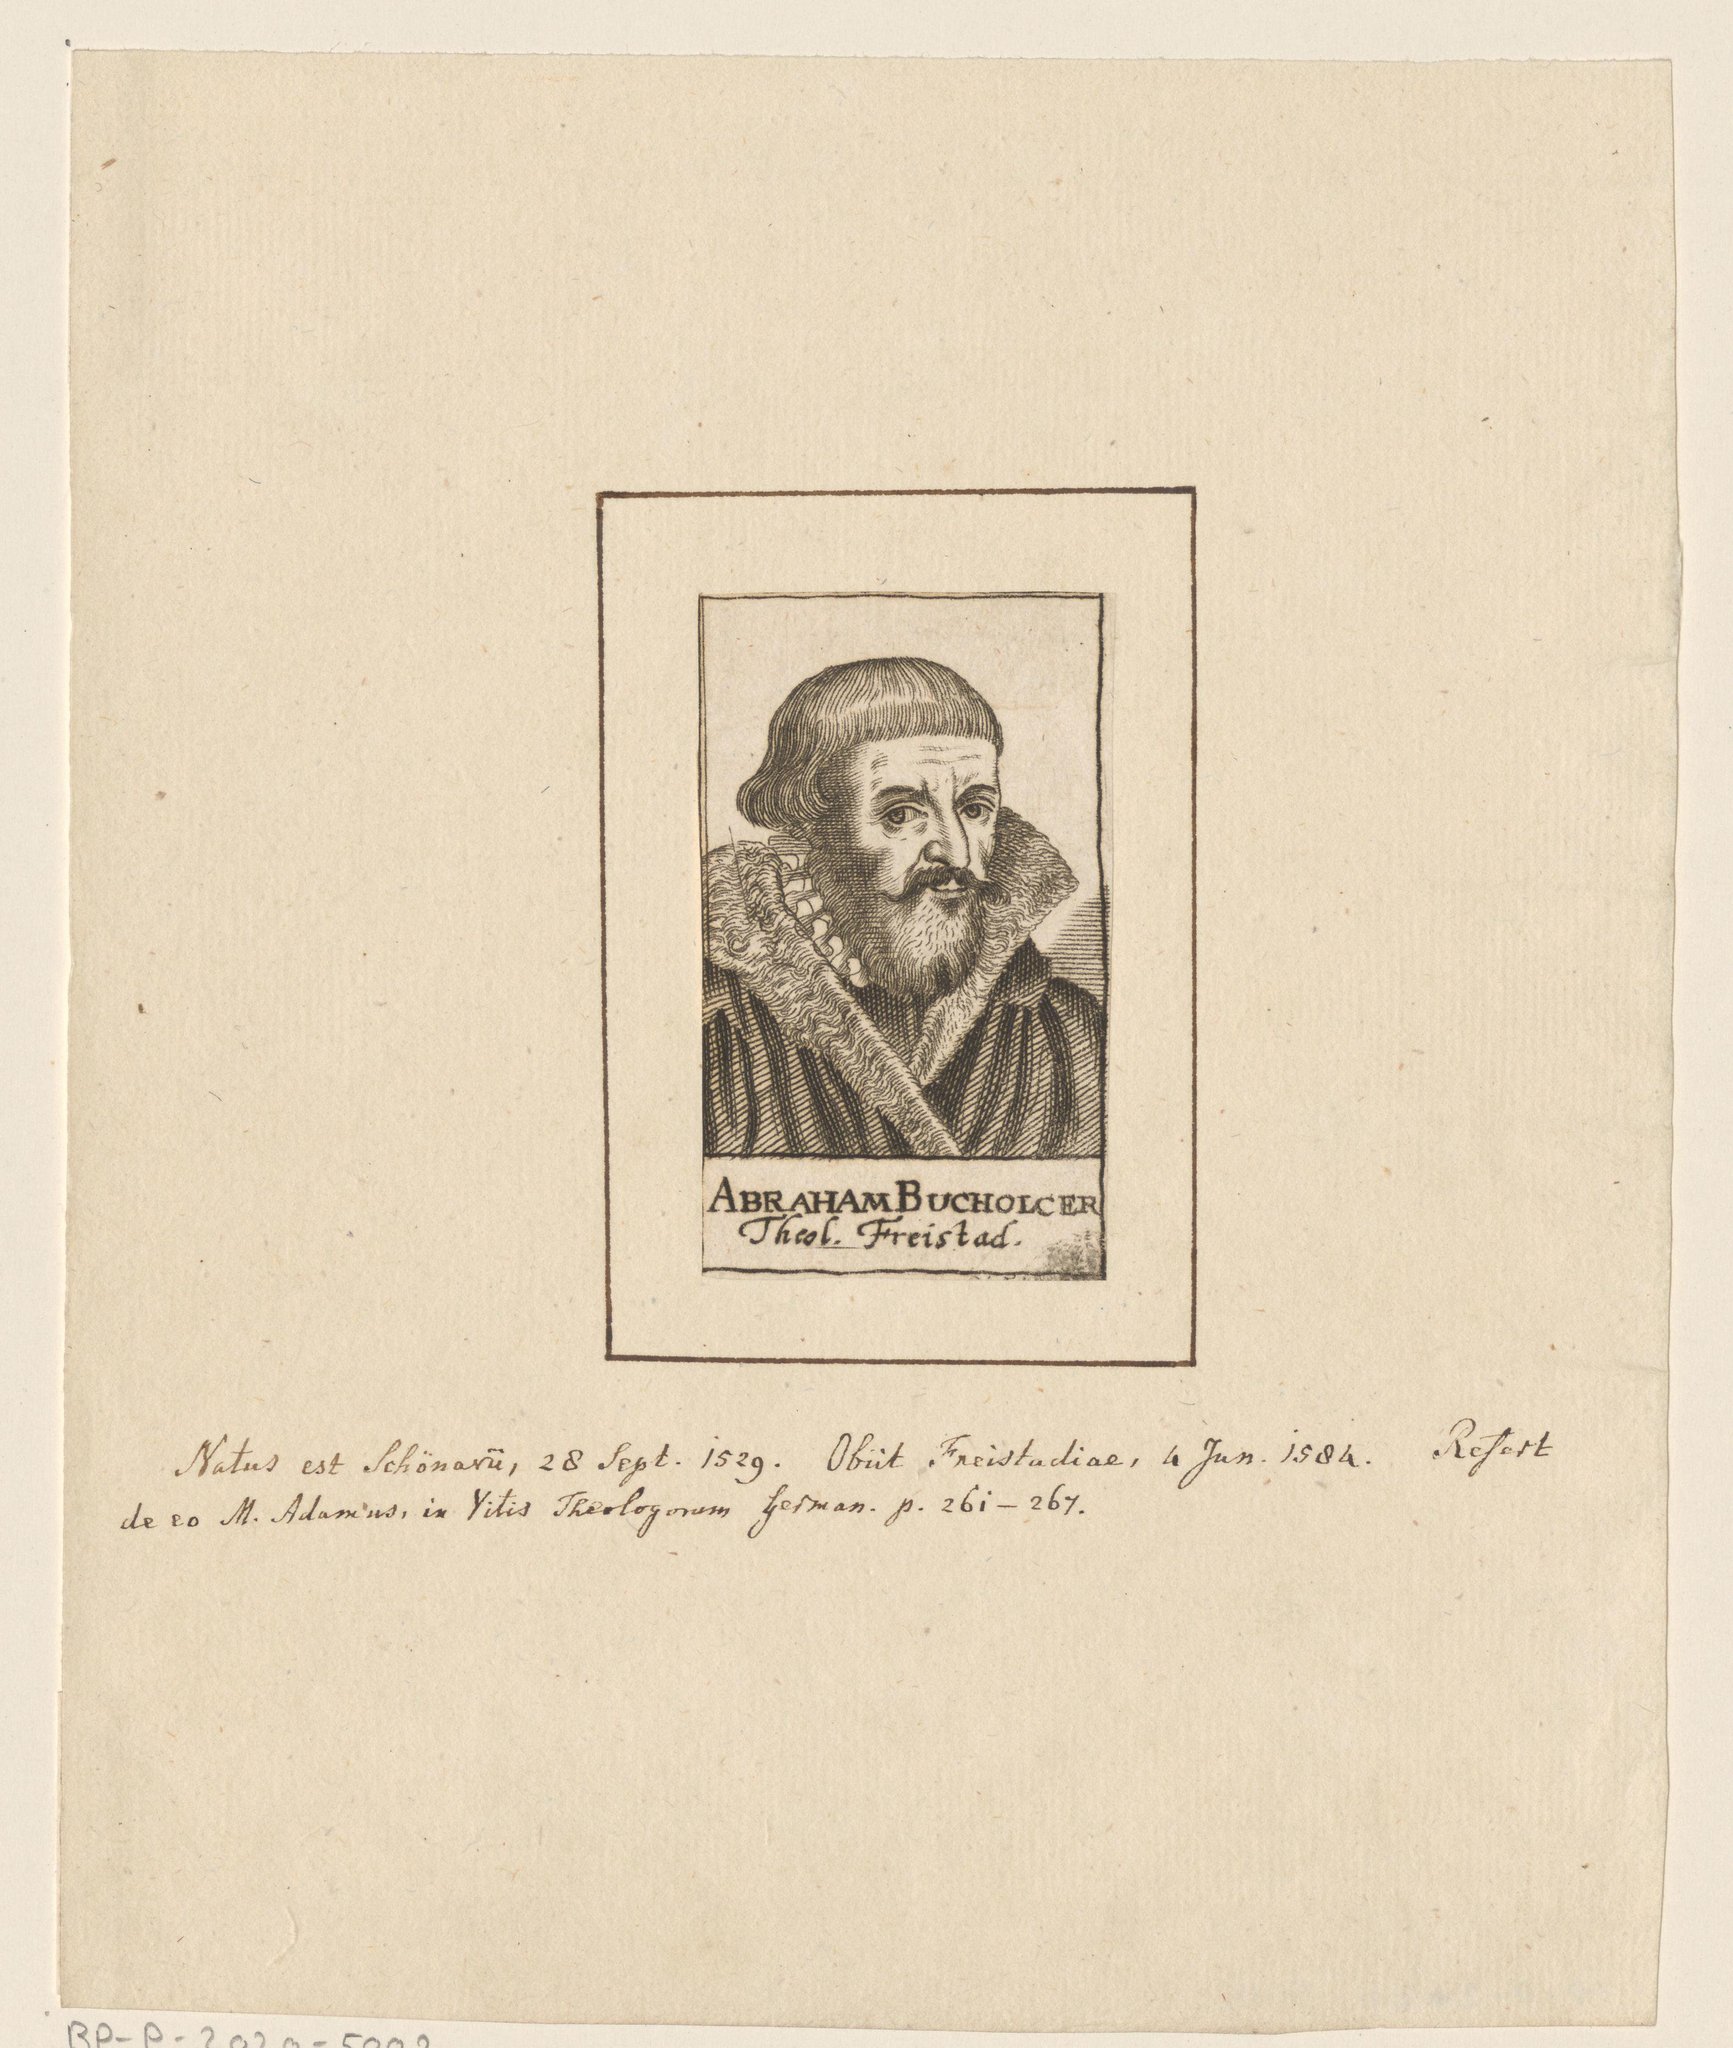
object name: print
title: Portret van Abraham Buchholzer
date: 1688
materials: paper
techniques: engraving, etching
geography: nuremberg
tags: theologian, historical persons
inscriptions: inscription: ‘Natus est Schönaru, 28 sept. 1529 (...)’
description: Prent uit: Freher, Paul. Theatrum virorum eruditione clarorum. Neurenberg: Johann Hoffmann, 1688.